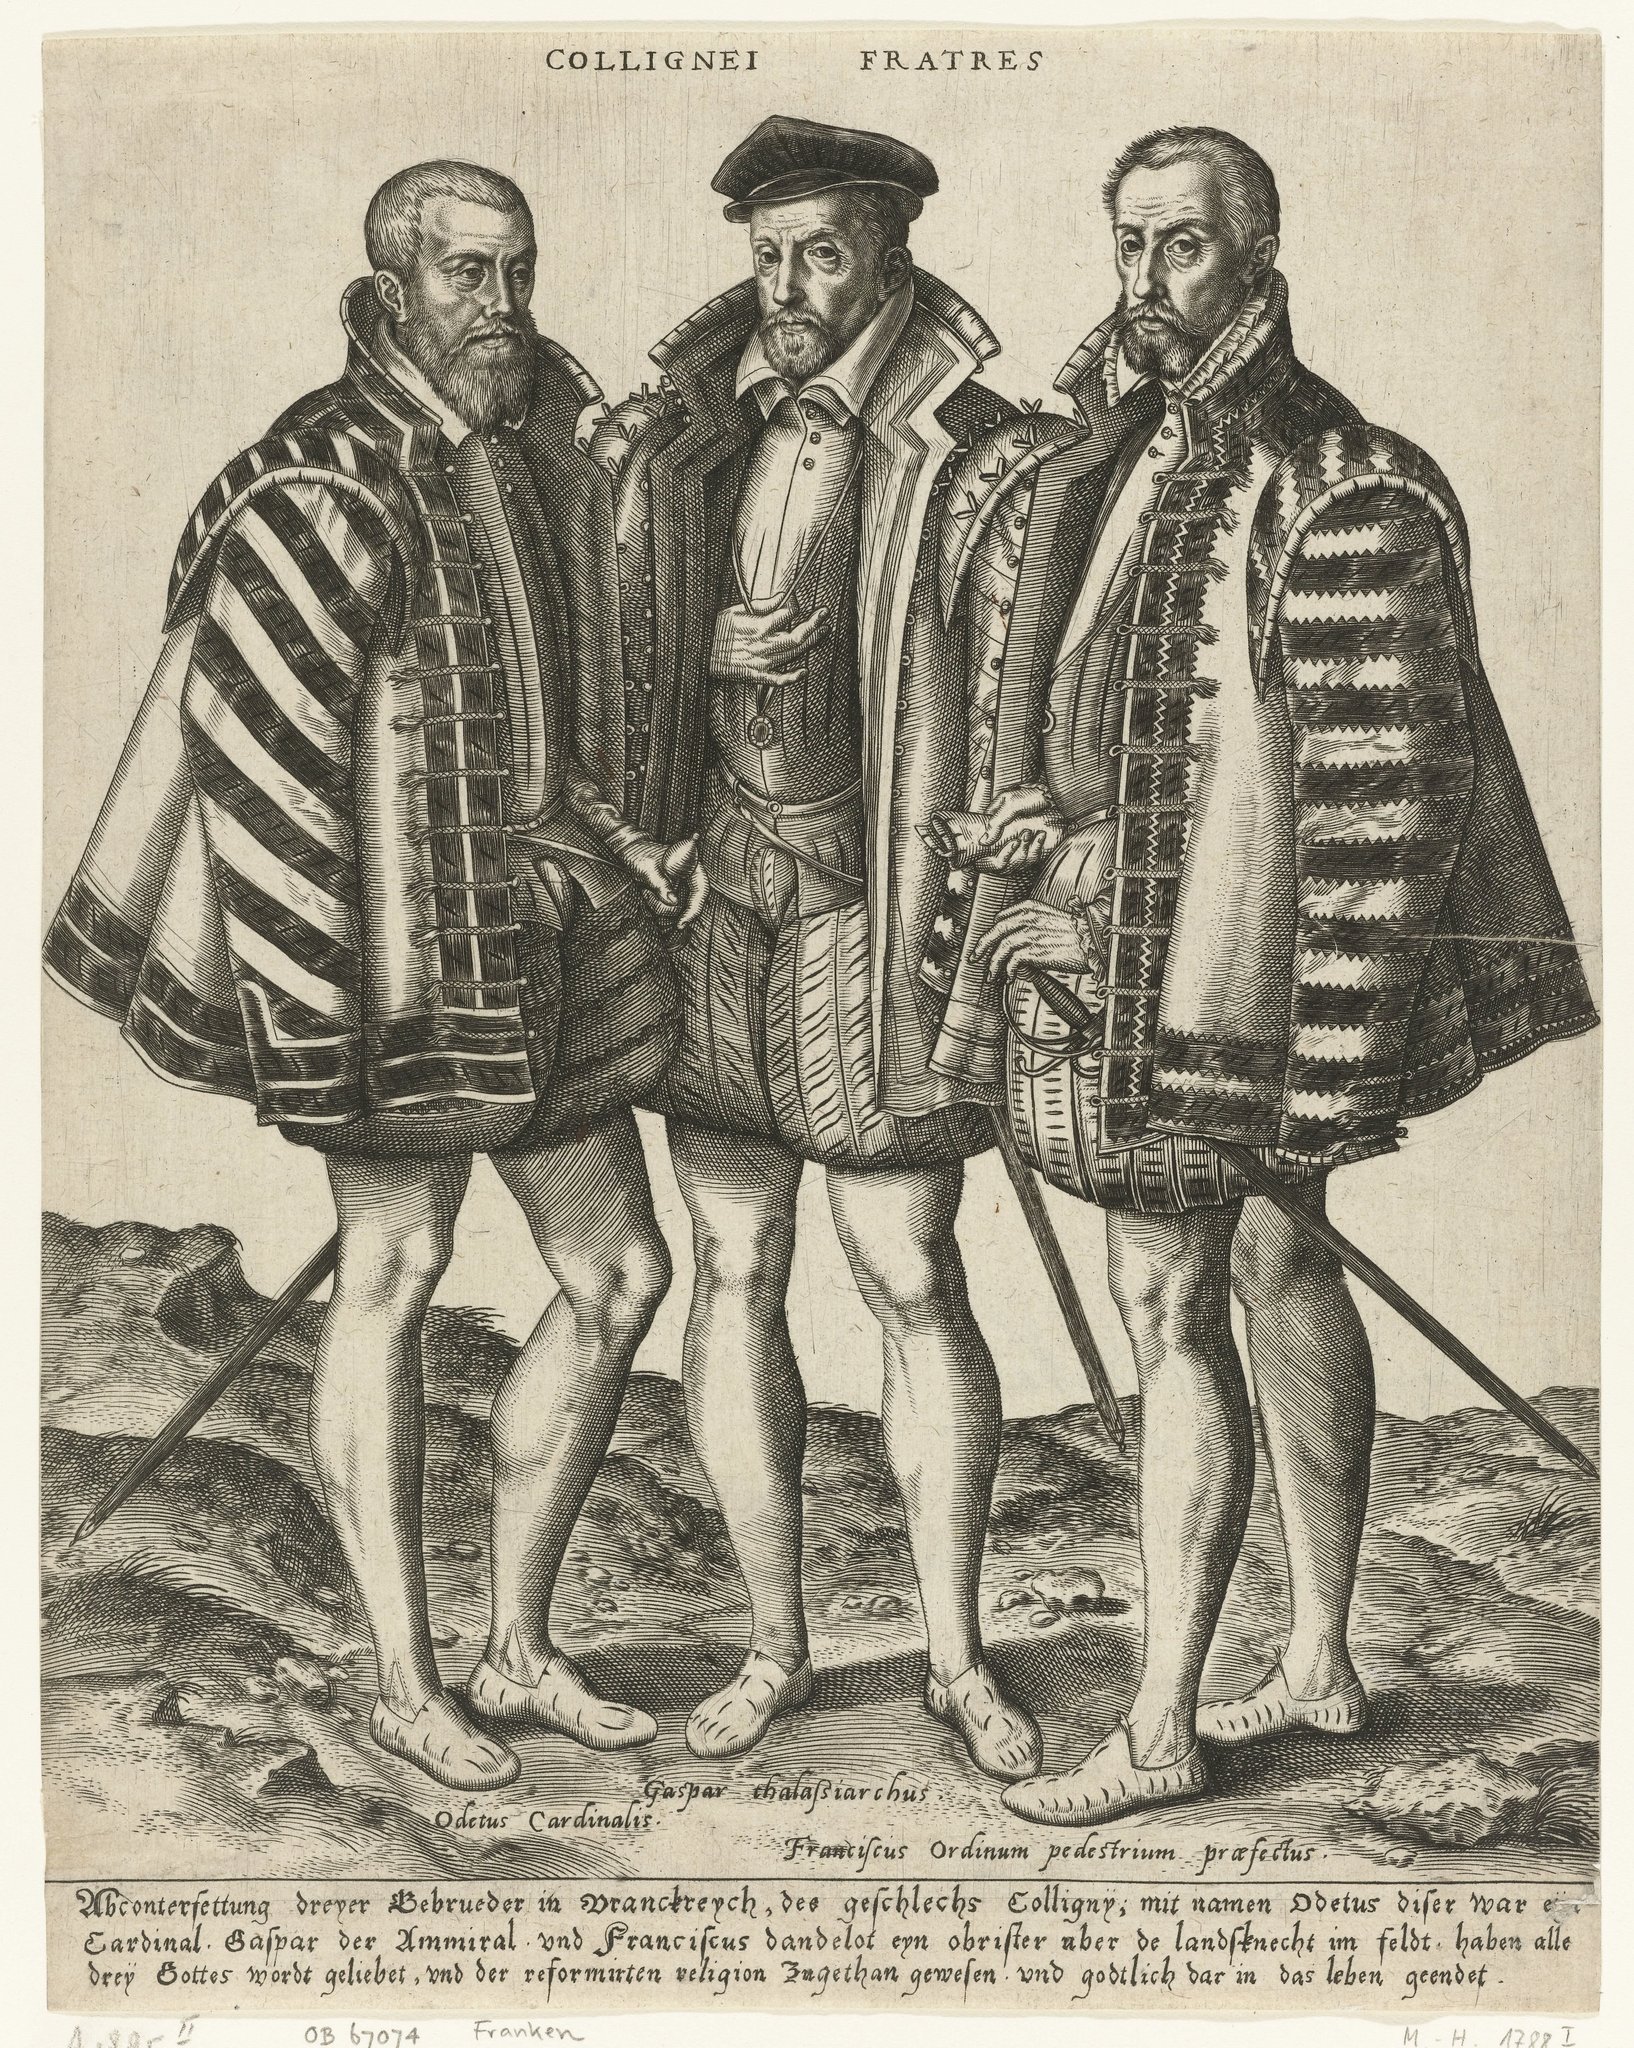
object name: print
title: Collignei Fratres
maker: Anonymous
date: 1579-1631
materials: paper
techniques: engraving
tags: paris, gaspard de coligny (ii), coat (+ men's clothes), head-gear: hat (+ men's clothes), shoes, sandals (+ men's clothes), clothes, costume (+ men's clothes), trousers, breeches, etc. (breeches) (+ men's clothes), clothing for the upper part of the body (doublet) (+ men's clothes), gloves, mittens, etc. (+ men's clothes), stockings, socks (+ men's clothes)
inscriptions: collector's mark: Lugt 964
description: Kleding: De drie mannen dragen een korte ballonvormige broek*, korte mantel* met passement*; van voren openvallende kleine kraag. De man in het midden draagt een bonnet* met platte bol en smalle rand. Platte schoenen* met spleten. Ihle p. 18, nr. 41: Odet, kardinaal van Châtillon (1517-1571), Gaspard, admiraal van Frankrijk en vader van Louise de Coligny (1519-1572) en Francois, generaal der infanterie (1521-1569) zijn in de volledige Spaanse dracht gekleed. Over het wambuis dragen ze ws. een met lange insnijdingen versierde leren kolder, een legerdracht. Daarover hebben zij het wijde Spaanse manteltje met mouwen. Gladde hemdkragen en ook een kraag met ruche. Schoenen met splitversiering.